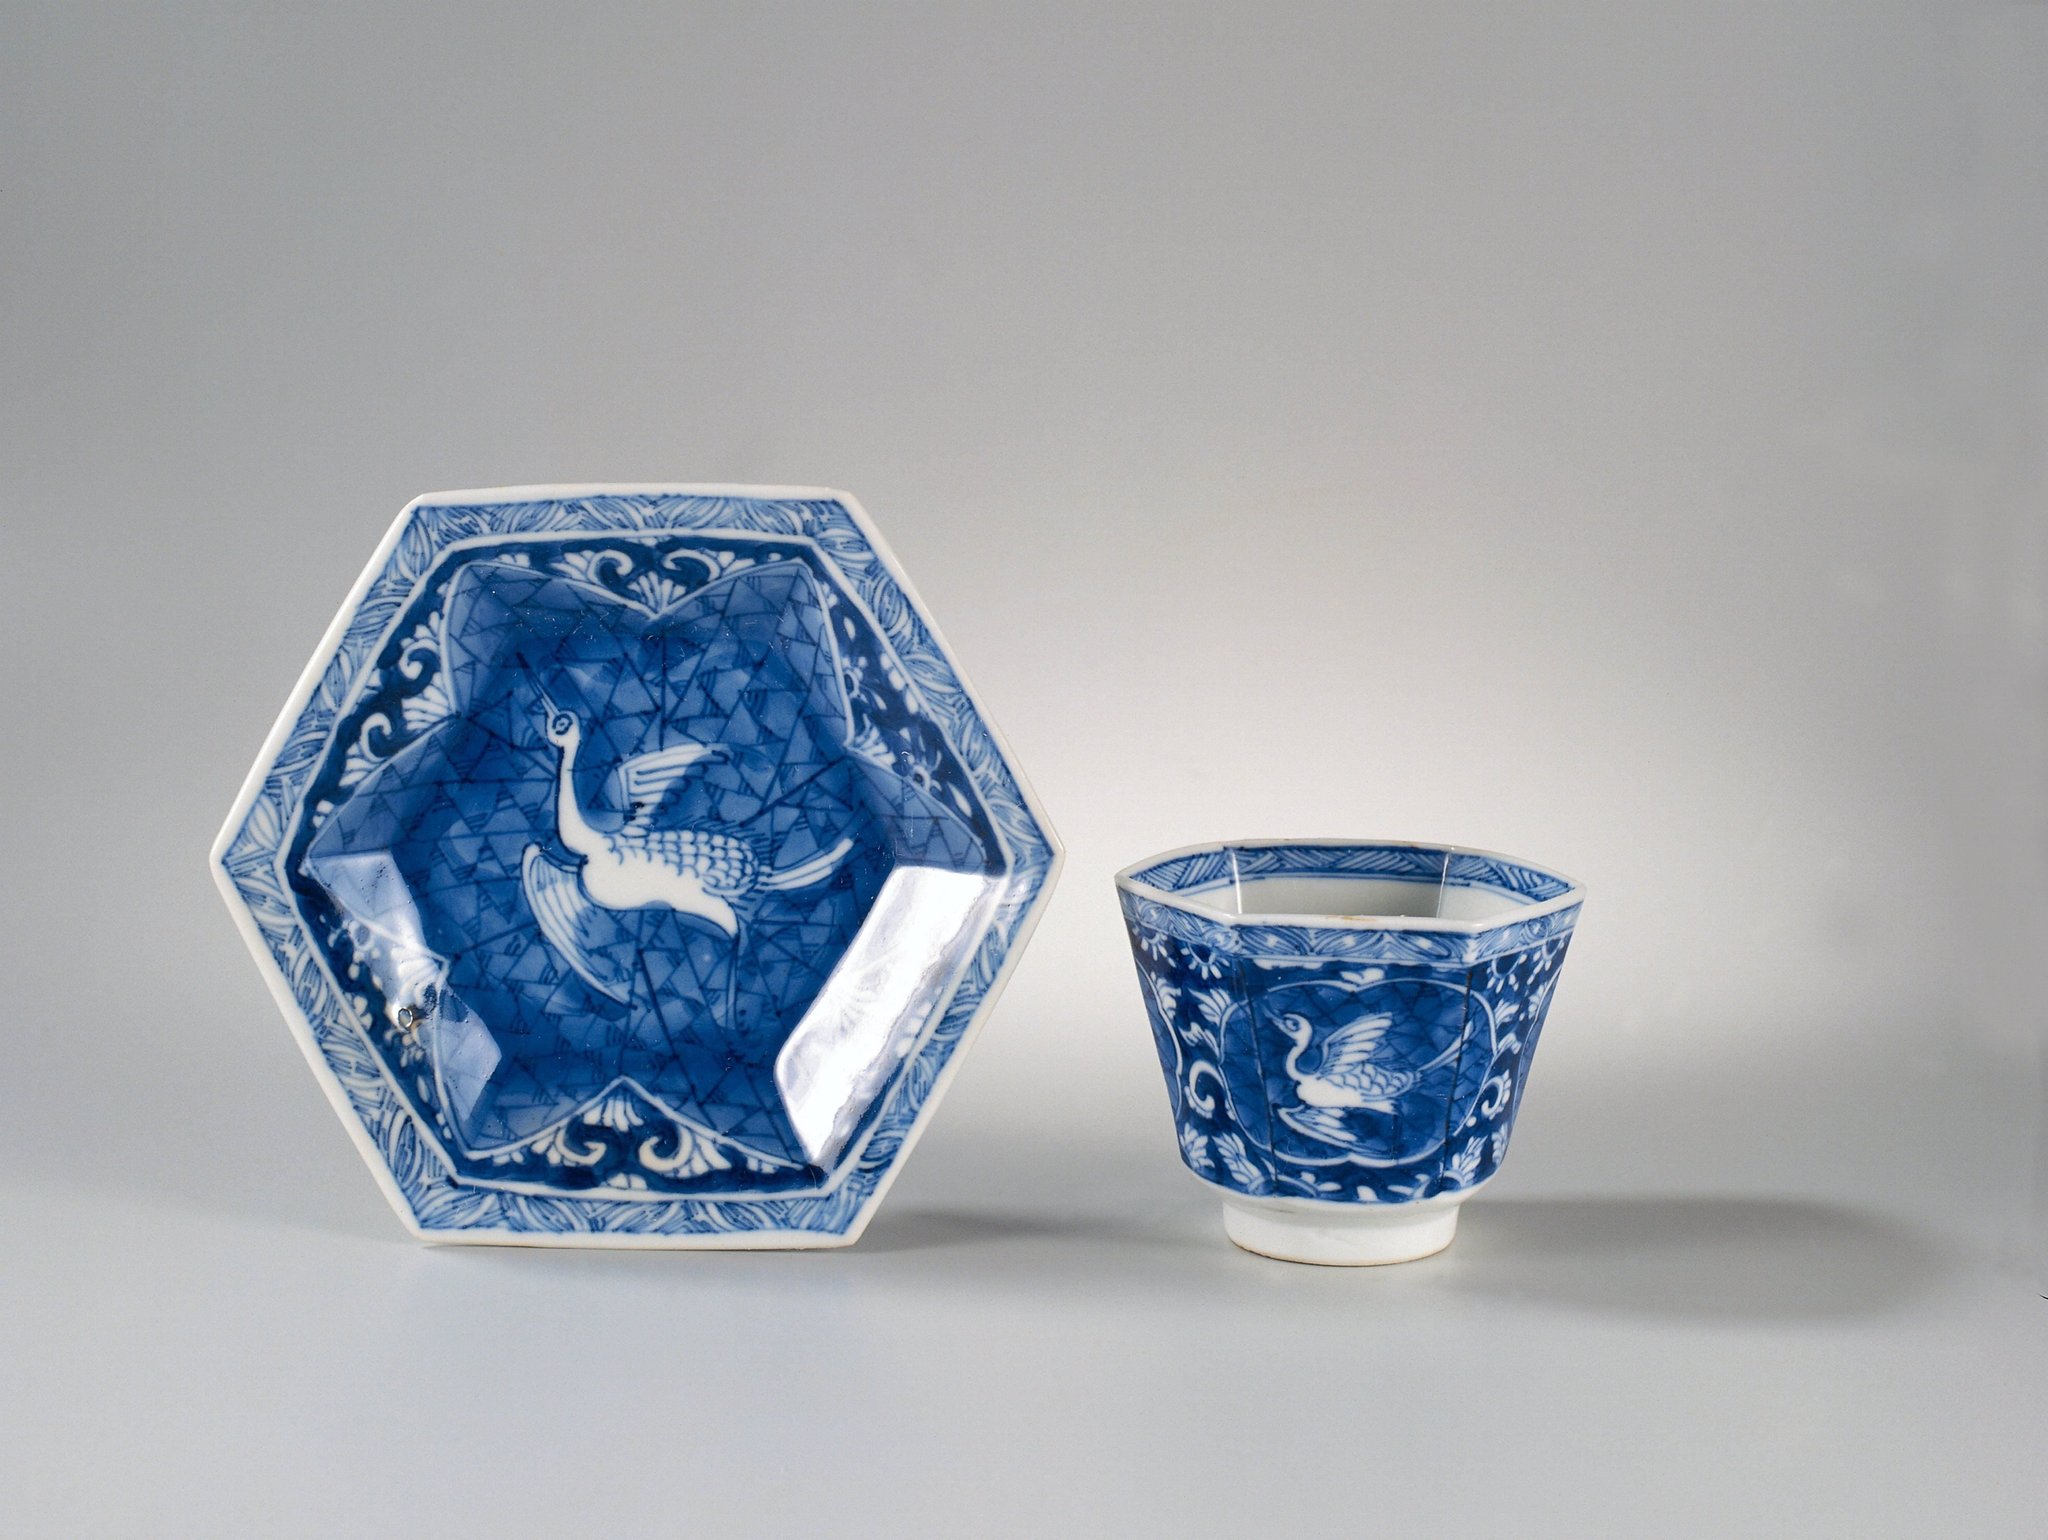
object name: platter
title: Pair of cups and saucers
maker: Anonymous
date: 1700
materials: cobalt, glaze, paint, porcelain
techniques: firing, forming, turning, vitrification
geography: china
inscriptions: mark: ‘福’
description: The drinking of tea was increasingly adopted in the West by the end of the 17th century. China had been closed for decades as the result of a civil war. When it ended, VOC merchants could once again buy porcelain from China, and the supply of tea and of teacups grew enormously. The hexagonal form of these cups is exceptional, just as is the crane in flight, set against a richly variegated blue background.